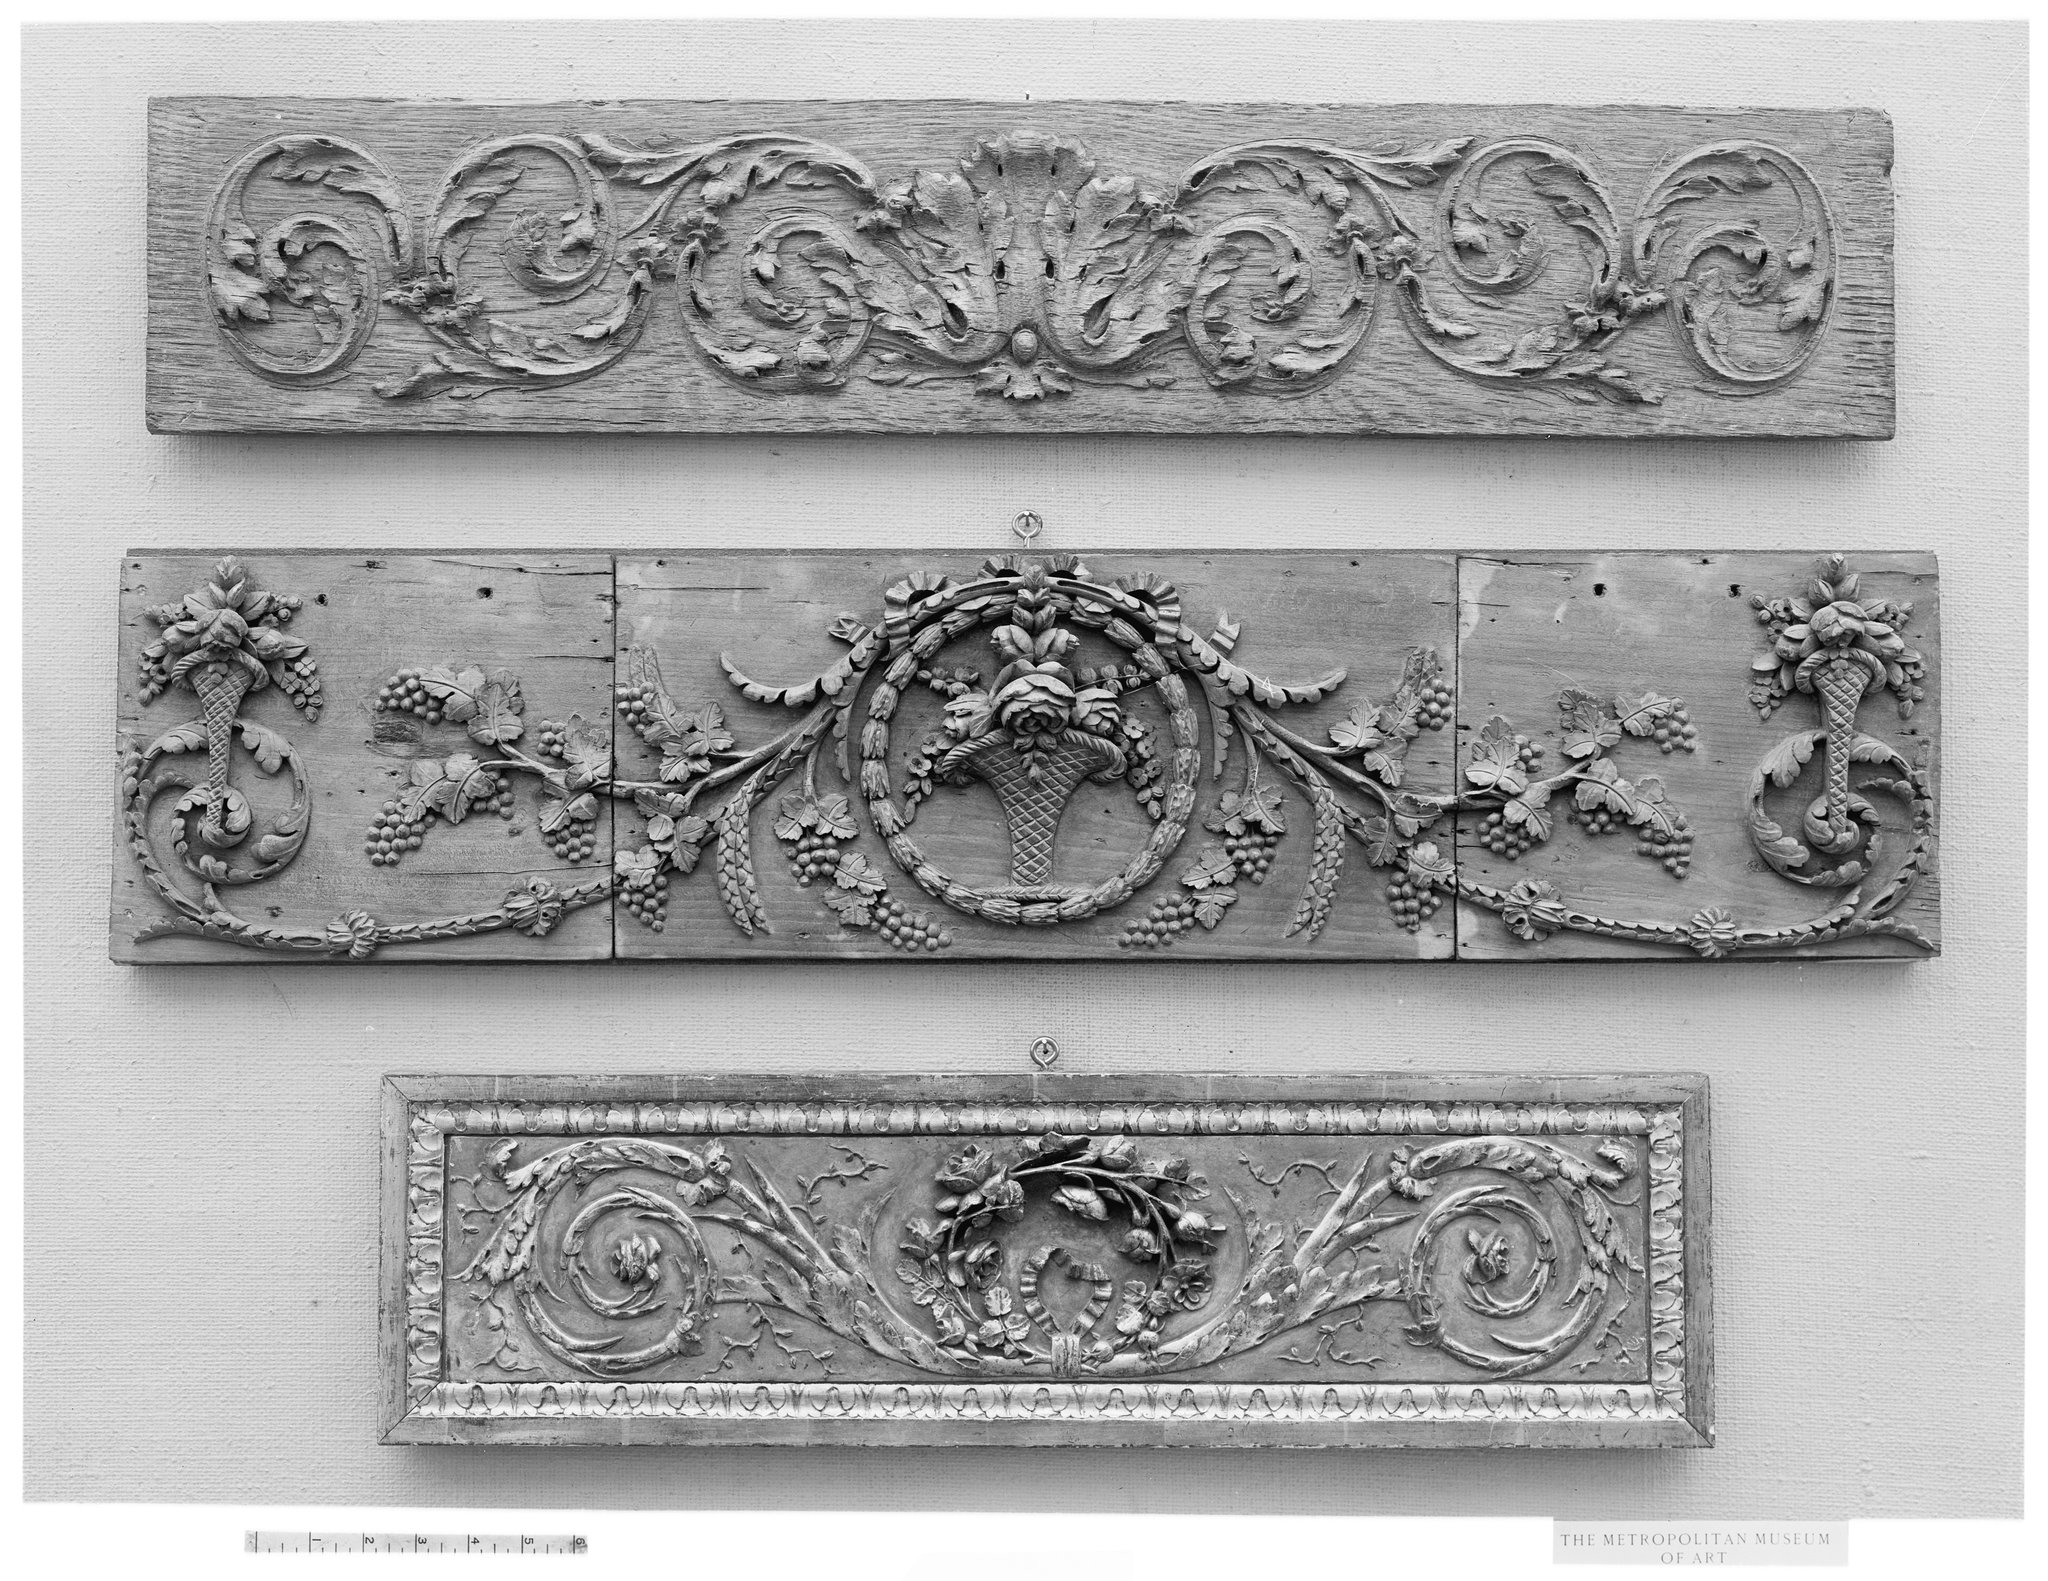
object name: frieze panel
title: Panel or frieze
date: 1701-1800